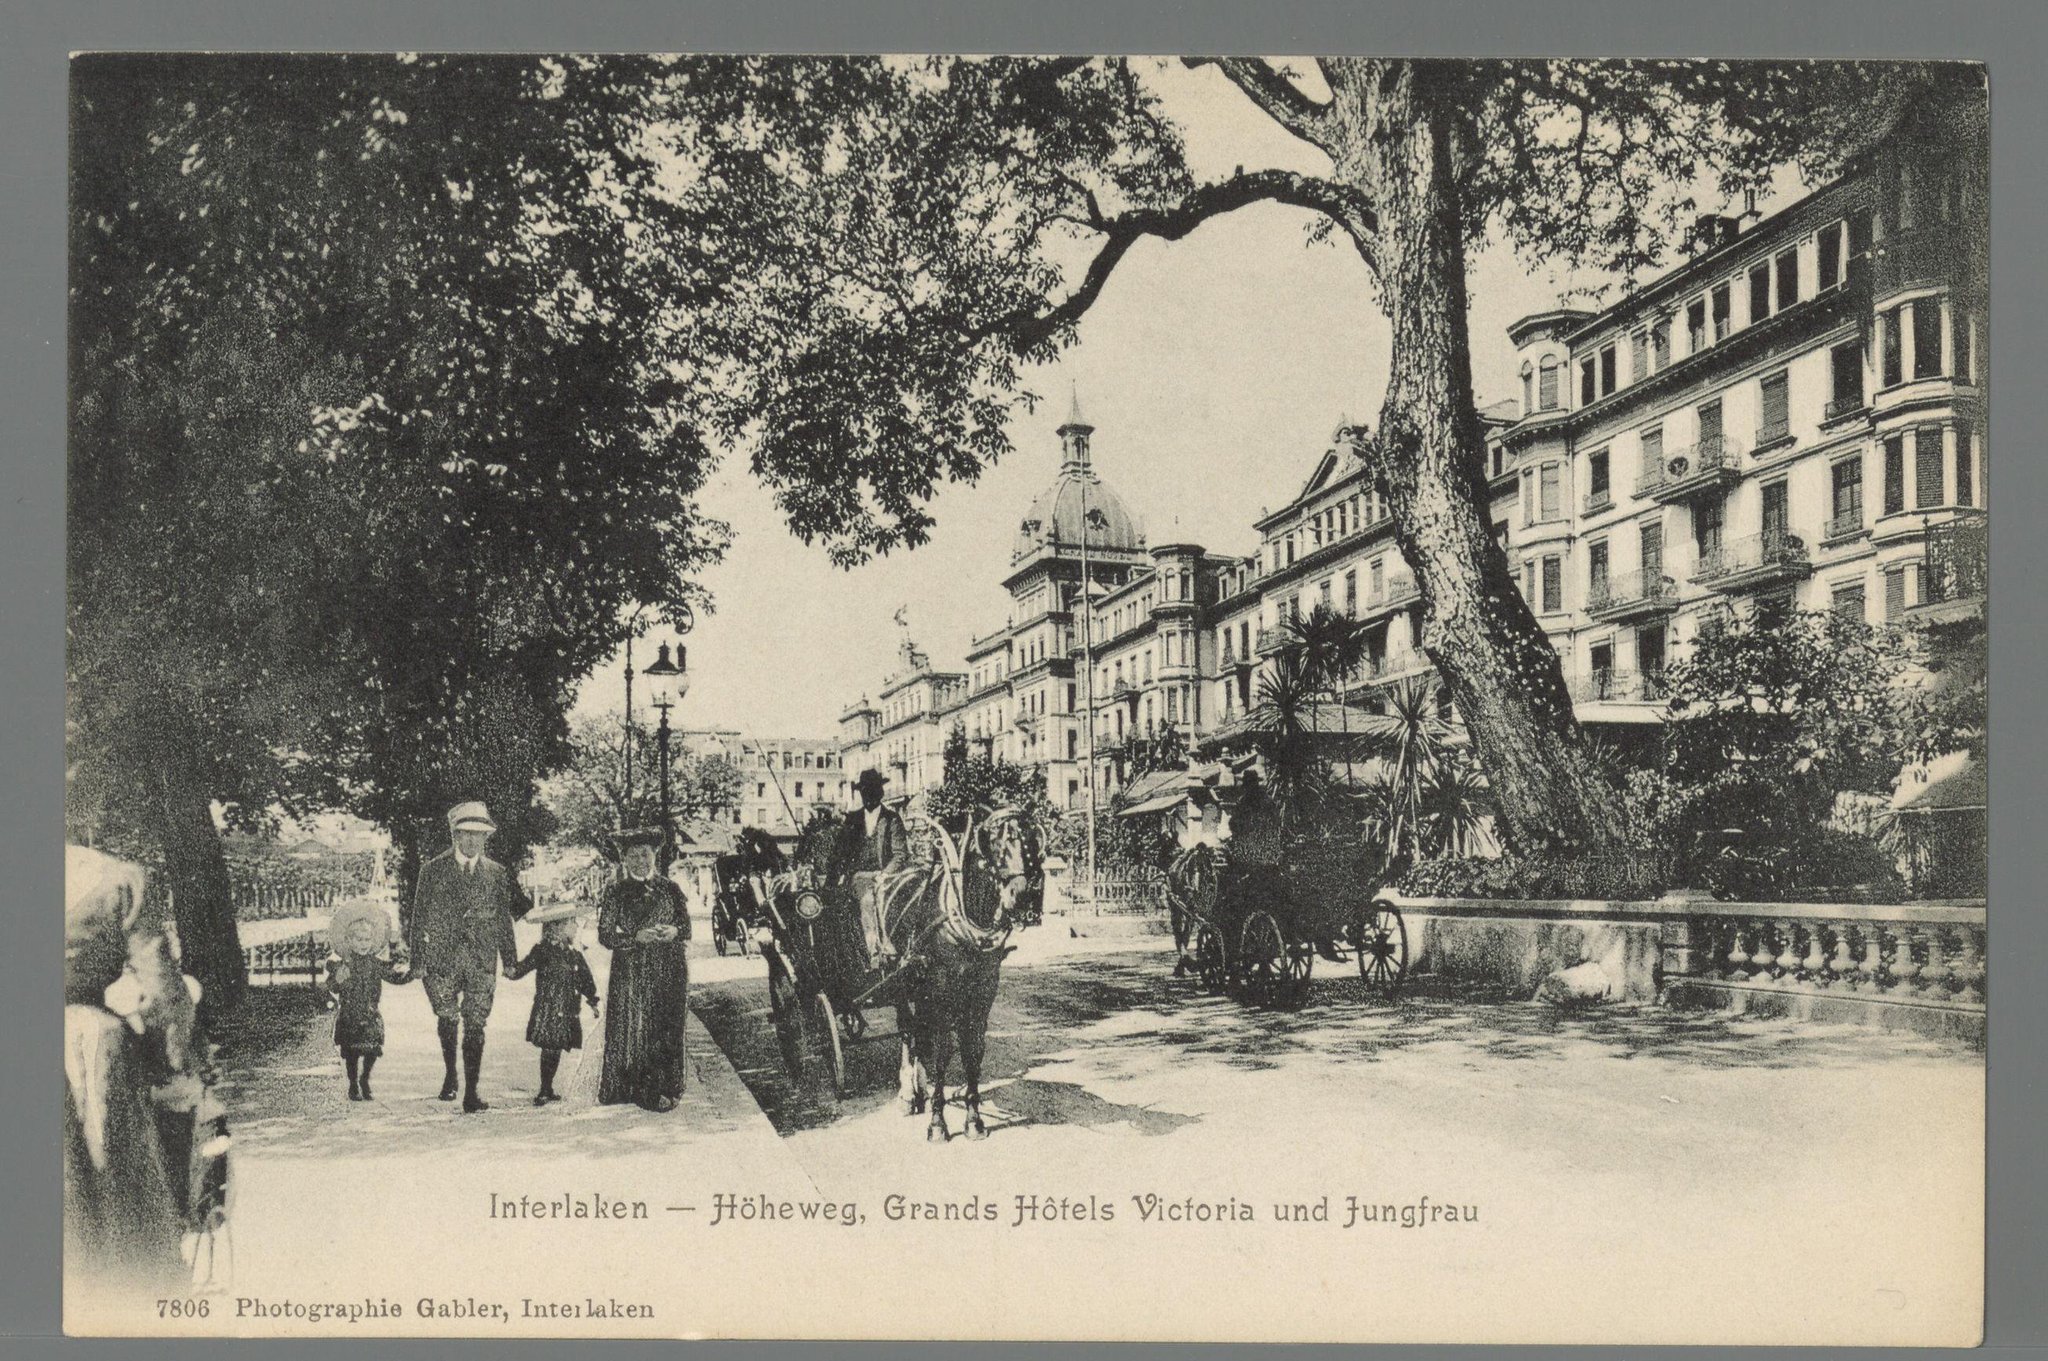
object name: photomechanical print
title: Interlaken. Höheweg, Grands Hôtels Victoria und Jungfrau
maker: Anonymous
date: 1890-1905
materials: cardboard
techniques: photograph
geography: interlaken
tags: trees, hotel, hostelry, inn, street (+ city(-scape) with figures, staffage)